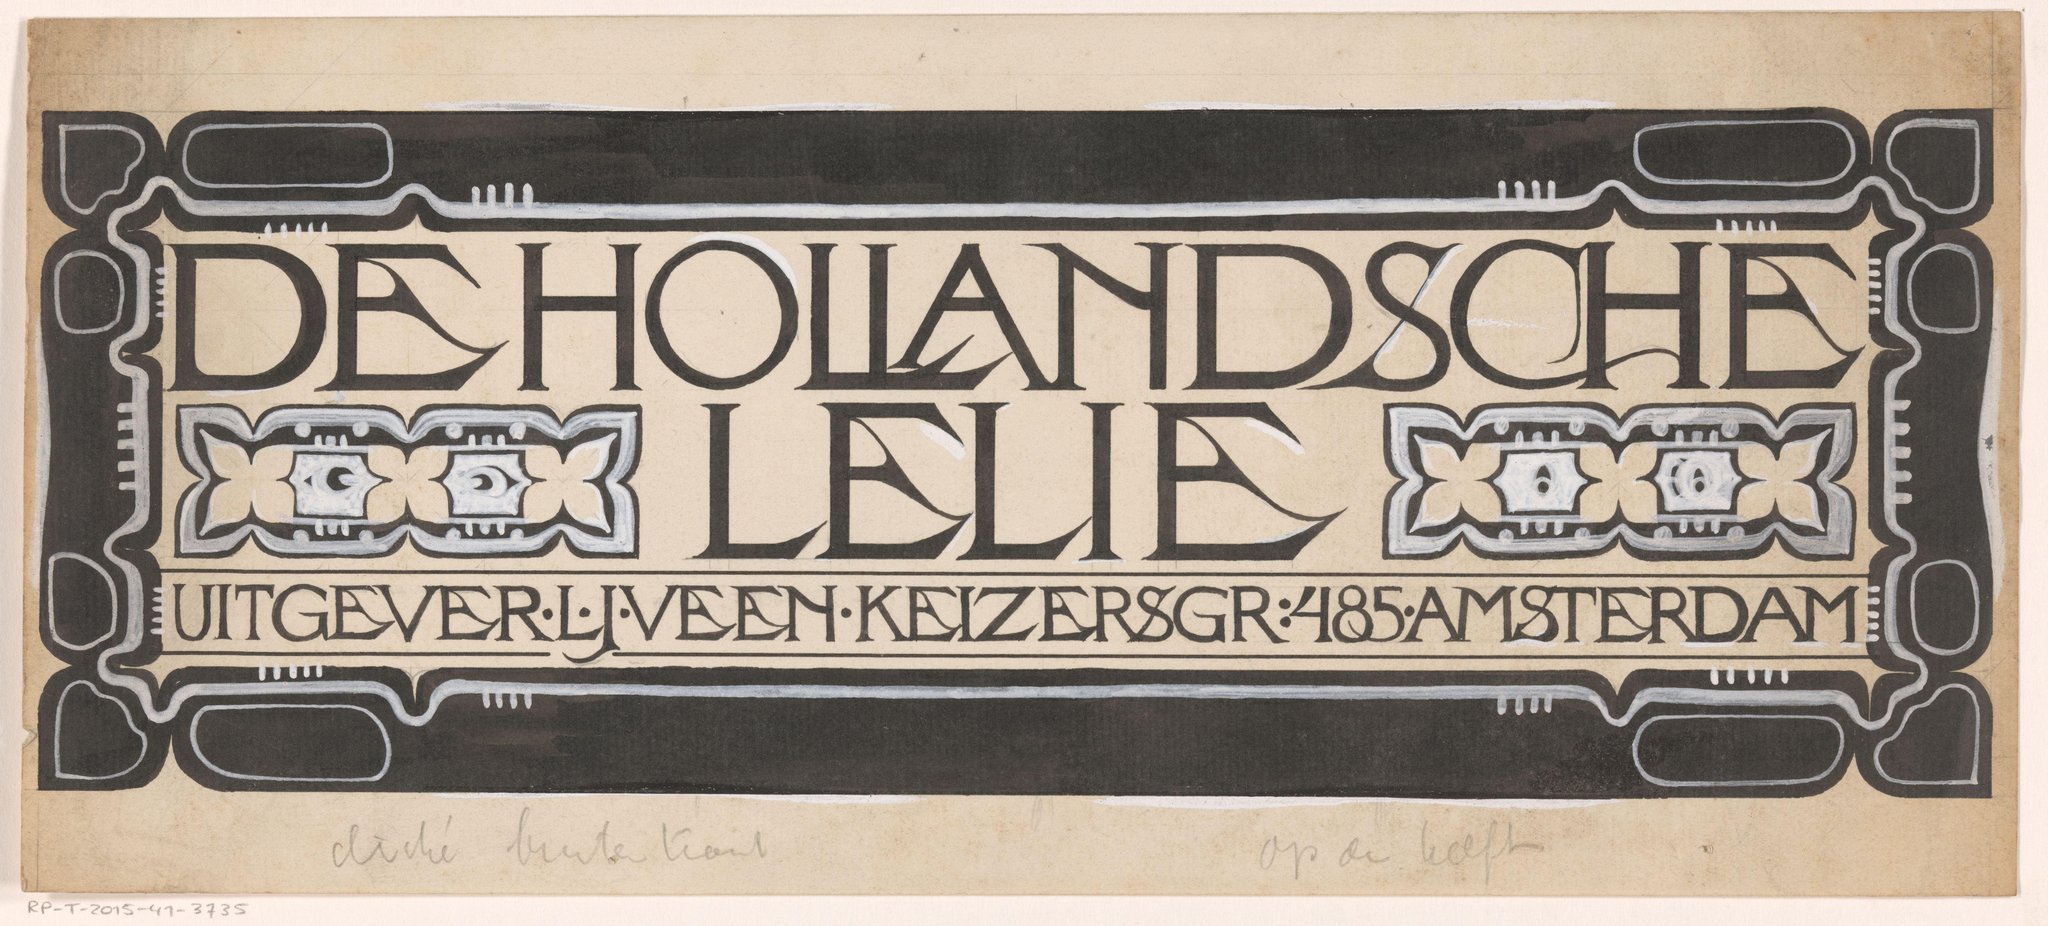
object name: design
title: Ontwerp voor: De Hollandsche Lelie, Weekblad voor jonge dames, c. 1892-1919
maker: Anonymous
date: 1892-1919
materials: paint, ink, paper, pencil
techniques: brush, pen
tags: flowers ~ ornament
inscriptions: number: ‘1282’, collector's mark: Lugt 2228a, :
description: Ontwerp met typografie en bloemornamenten.